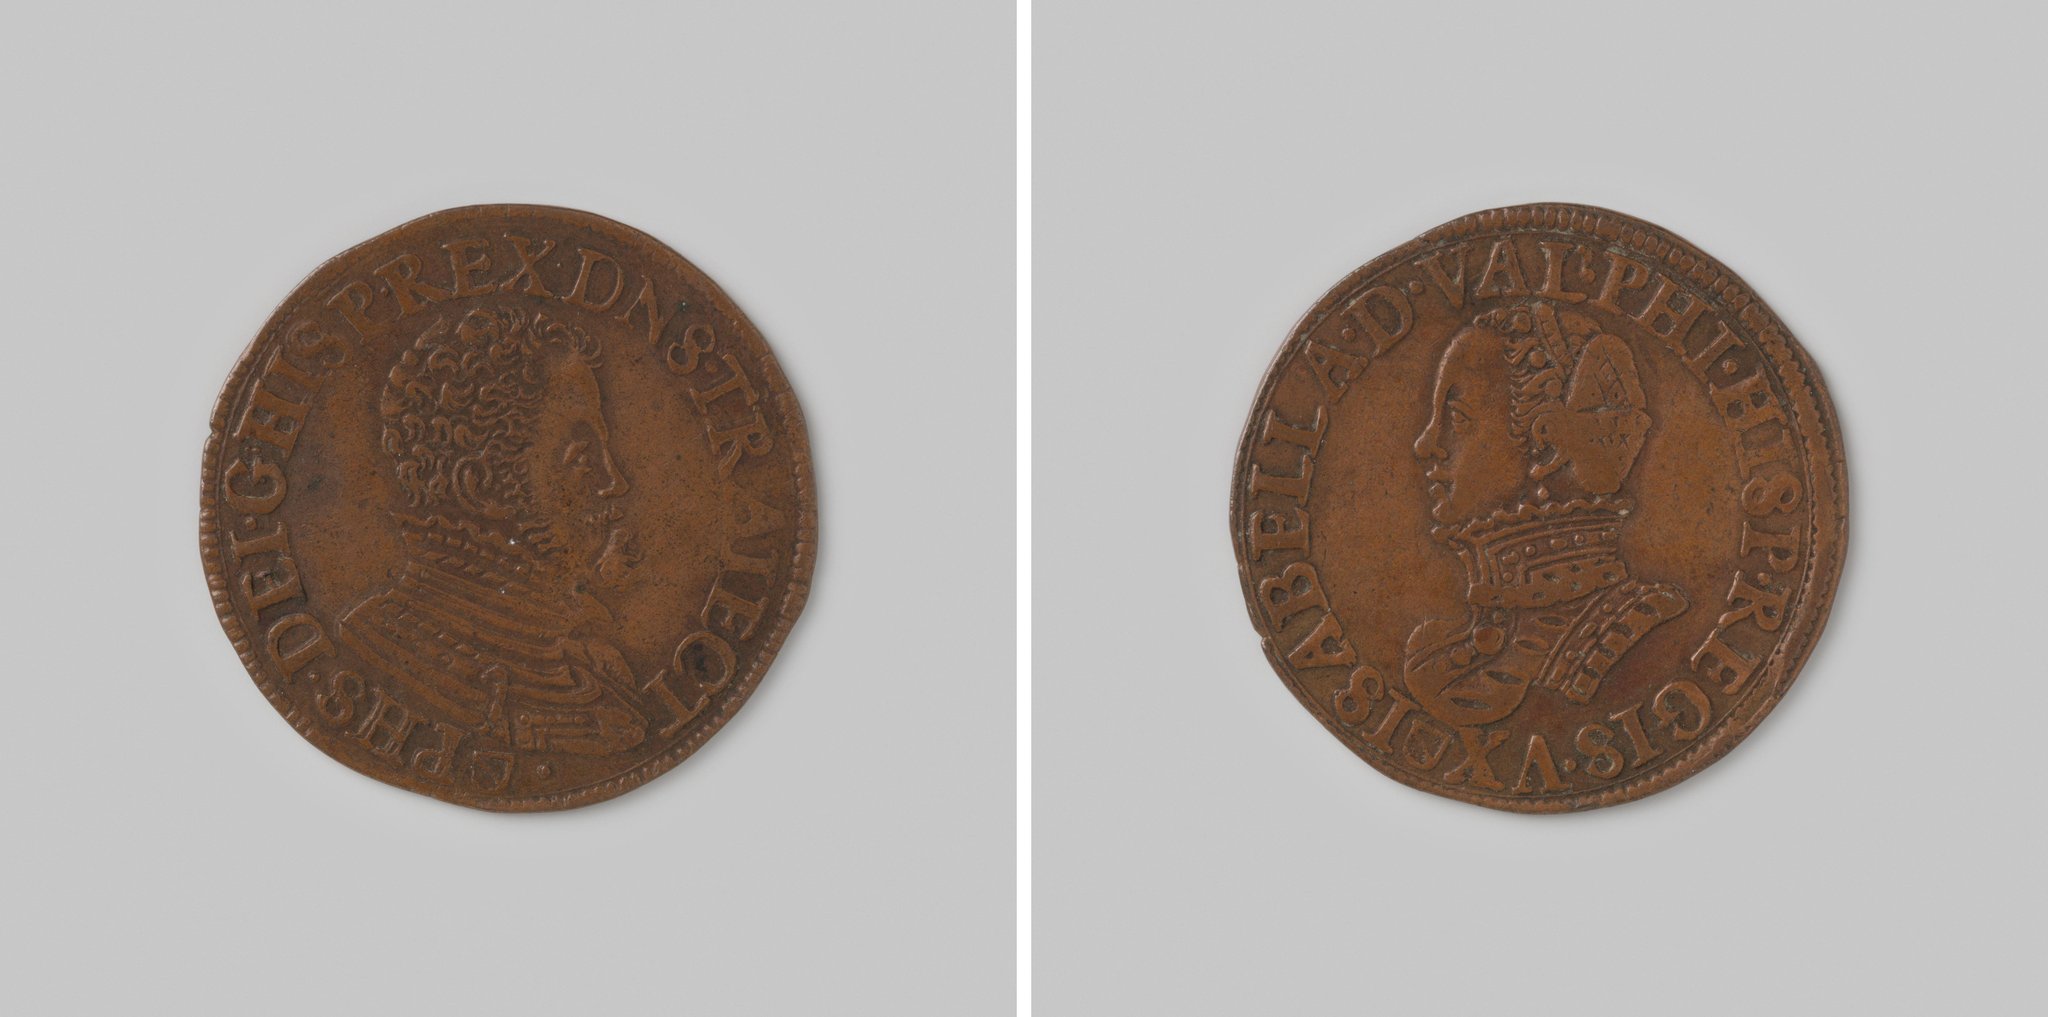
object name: history medal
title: Rekenpenning uit Utrecht op het huwelijk van Philips II met Isabella van Frankrijk 1559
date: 1559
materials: copper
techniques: striking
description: Koperen penning, op de voorzijde het borstbeeld van Philips II naar rechts met omschrift, op de keerzijde het borstbeeld van Isabella naar links met omschrift.